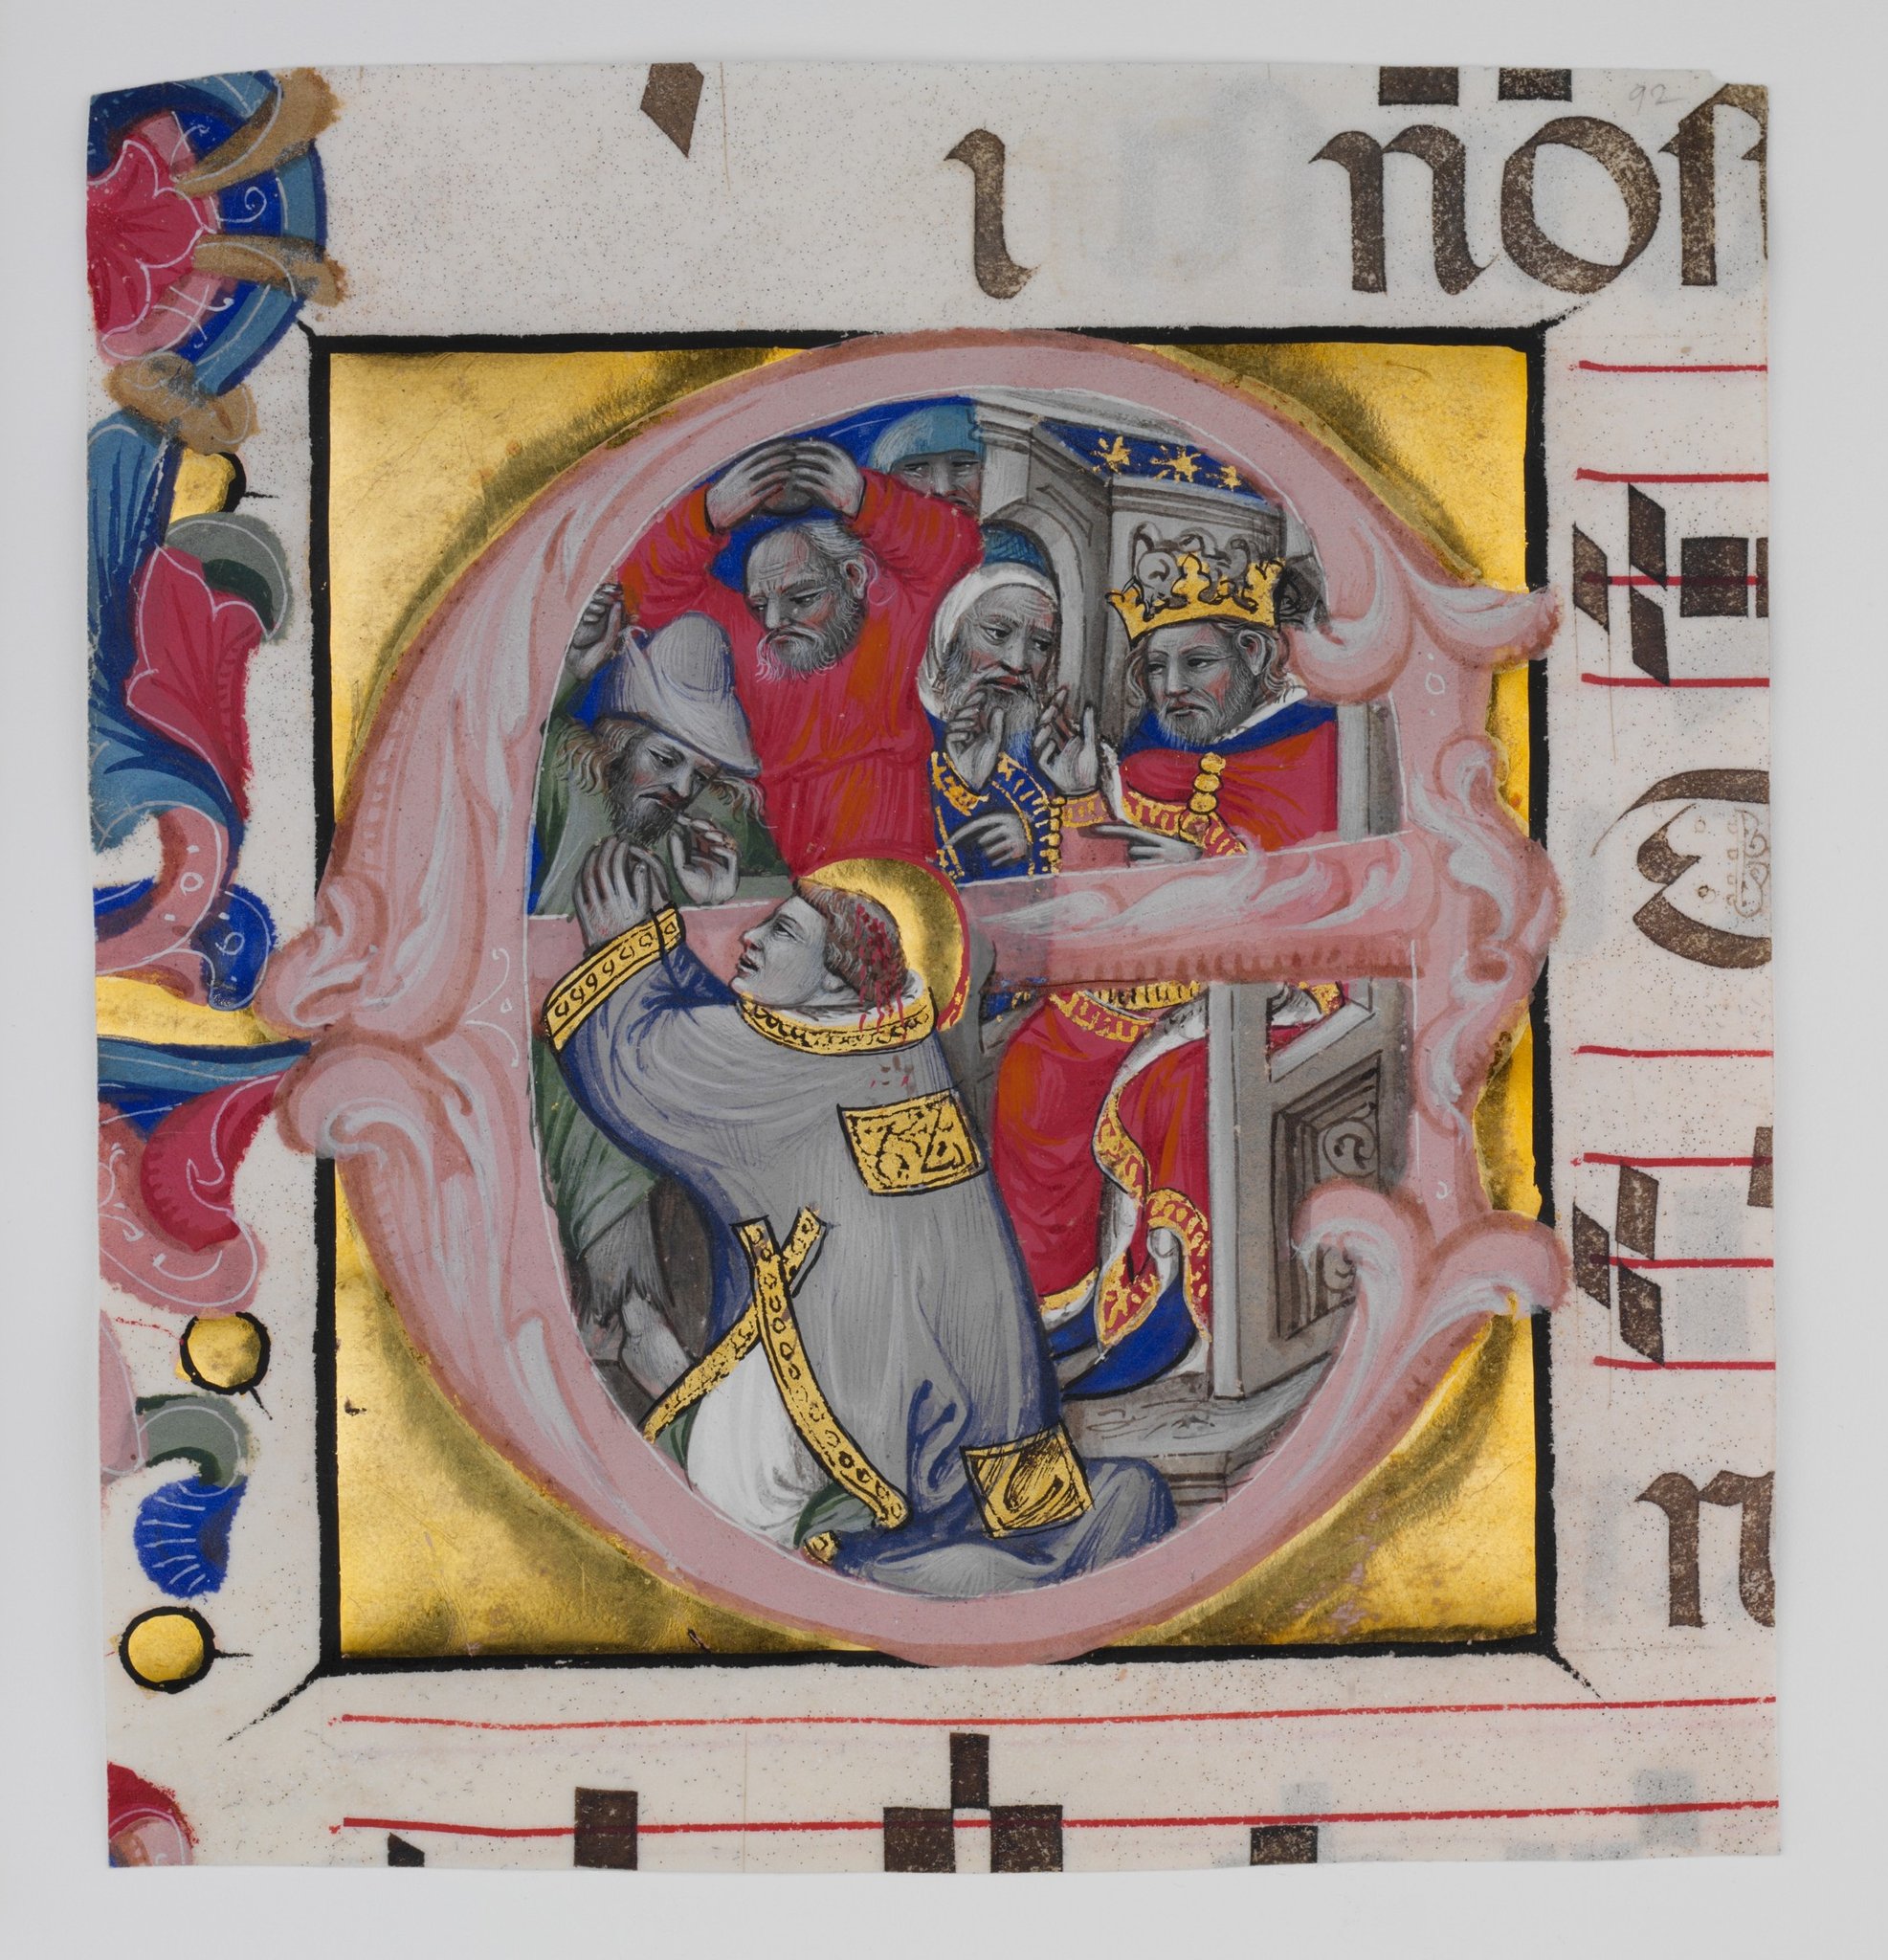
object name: gradual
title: Manuscript Illumination with the Martyrdom of Saint Stephen in an Initial E, from a Gradual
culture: italian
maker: niccolò di giacomo da bologna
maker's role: artist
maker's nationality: italian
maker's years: 1349-1403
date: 1394-1402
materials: gold, ink, parchment, paint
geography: italy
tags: men,saints